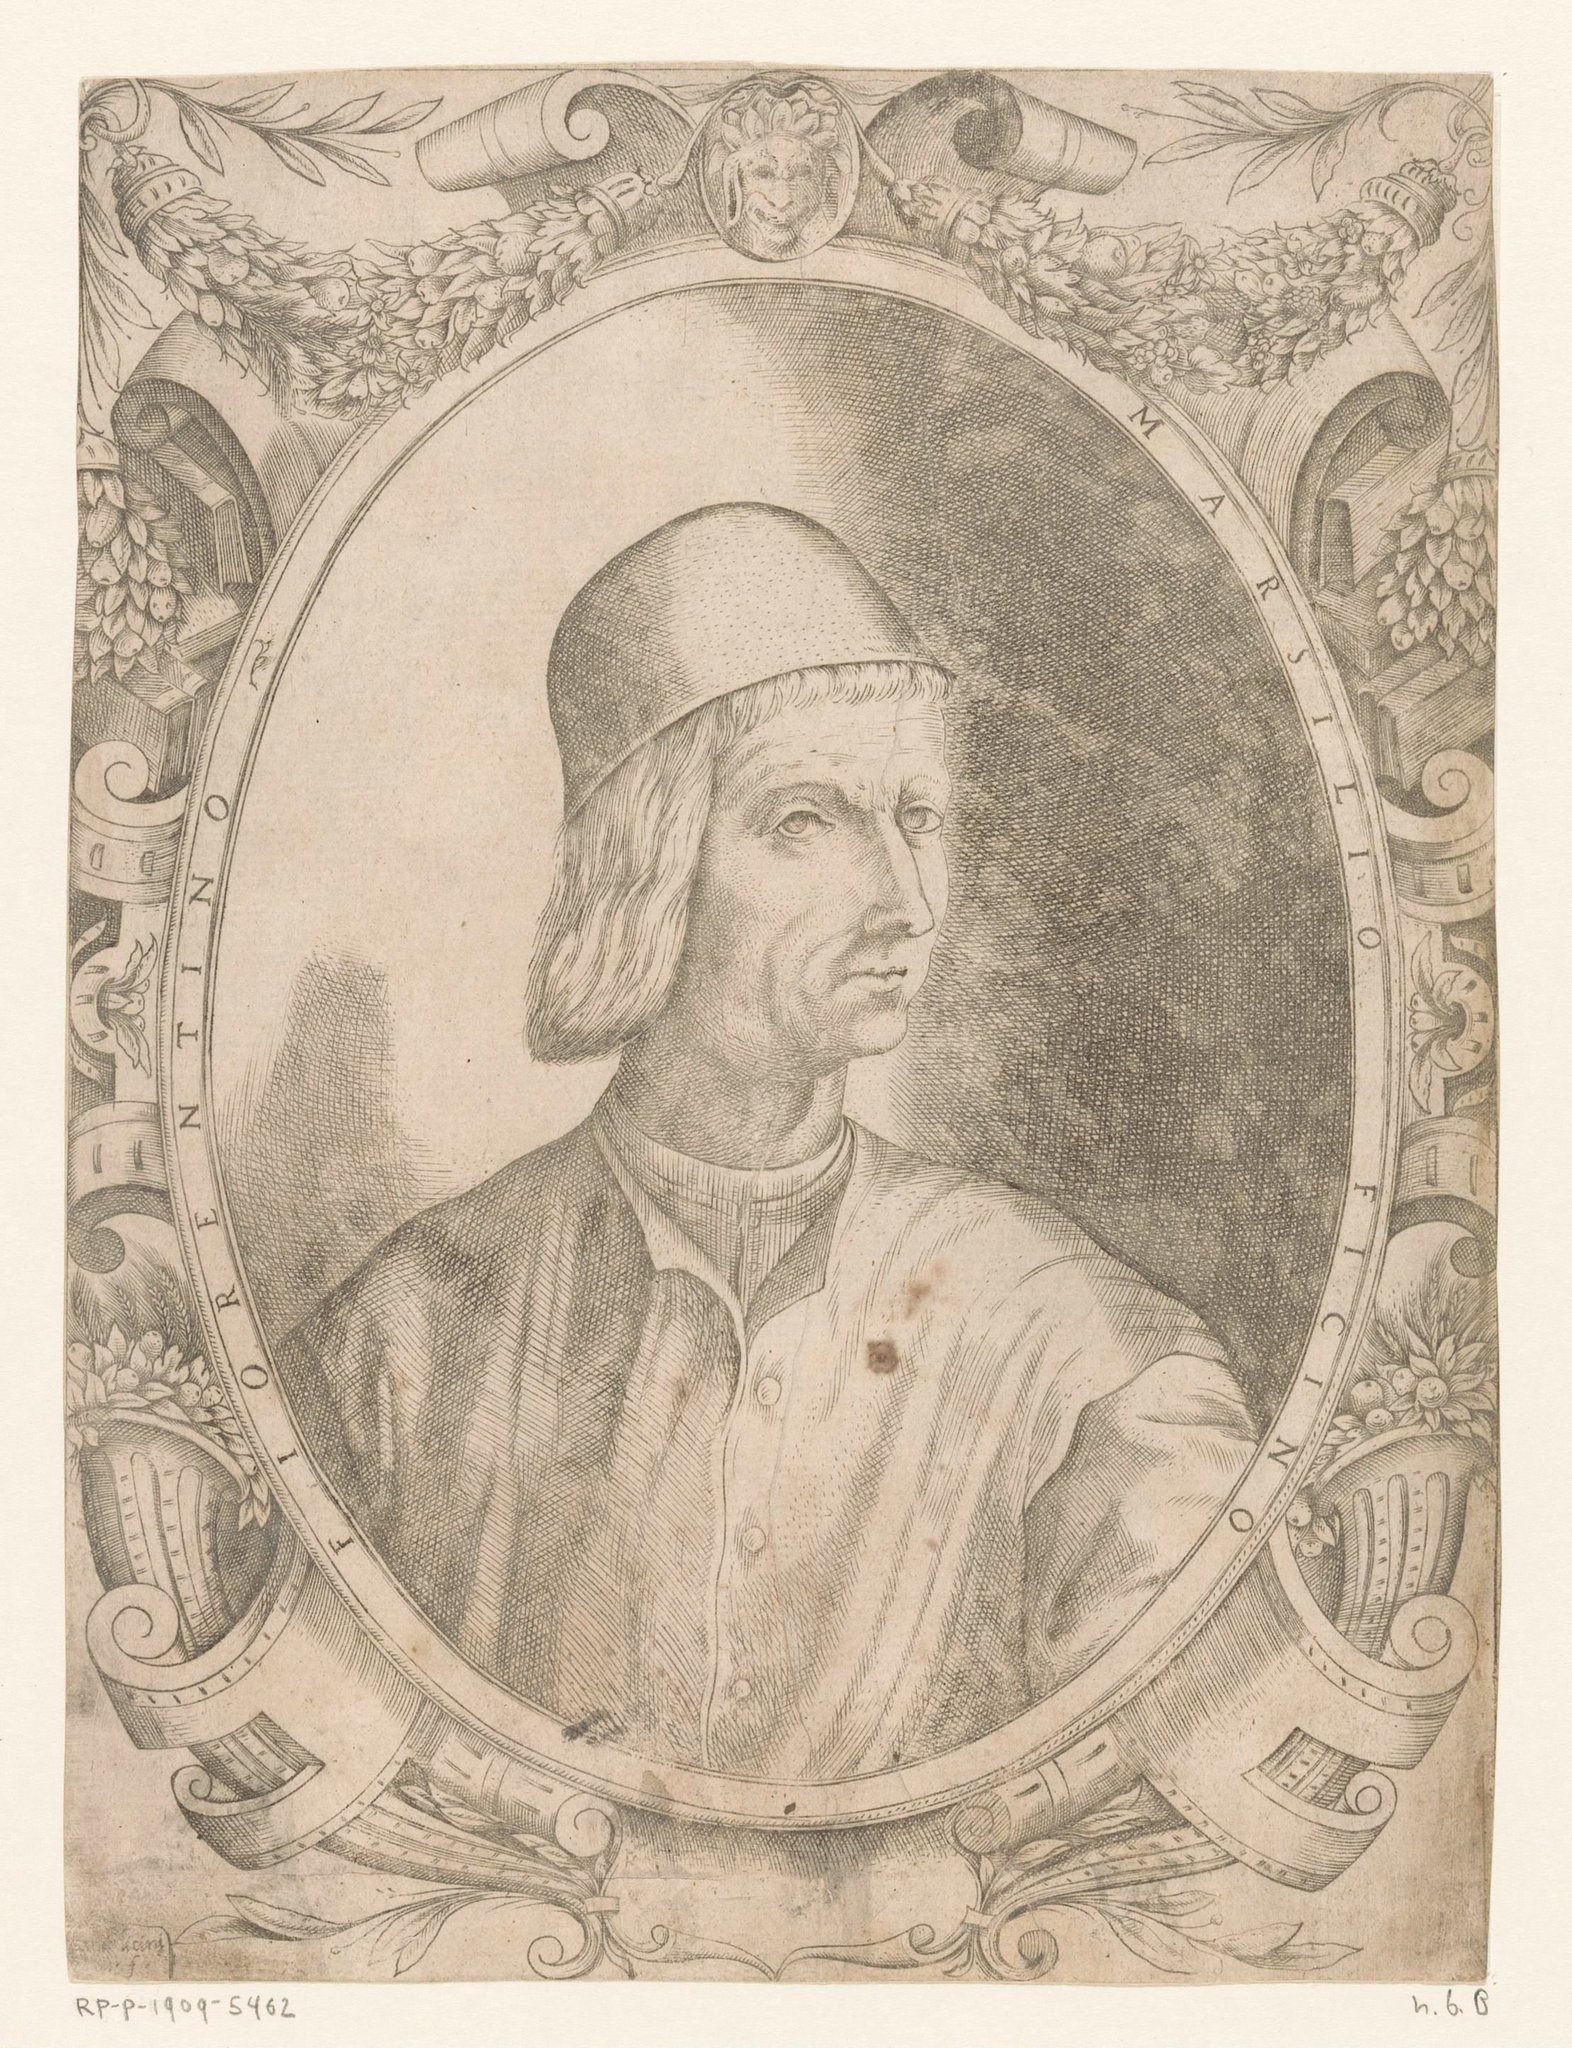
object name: print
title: Portret van filosoof Marsilio Ficino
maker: enea vico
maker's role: draughtsman, print maker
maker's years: 1523-1567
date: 1533-1567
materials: paper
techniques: engraving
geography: italy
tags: historical persons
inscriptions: collector's mark: Lugt 2228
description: Portret van Marsilio Ficino, gevat in een geornamenteerde lijst.